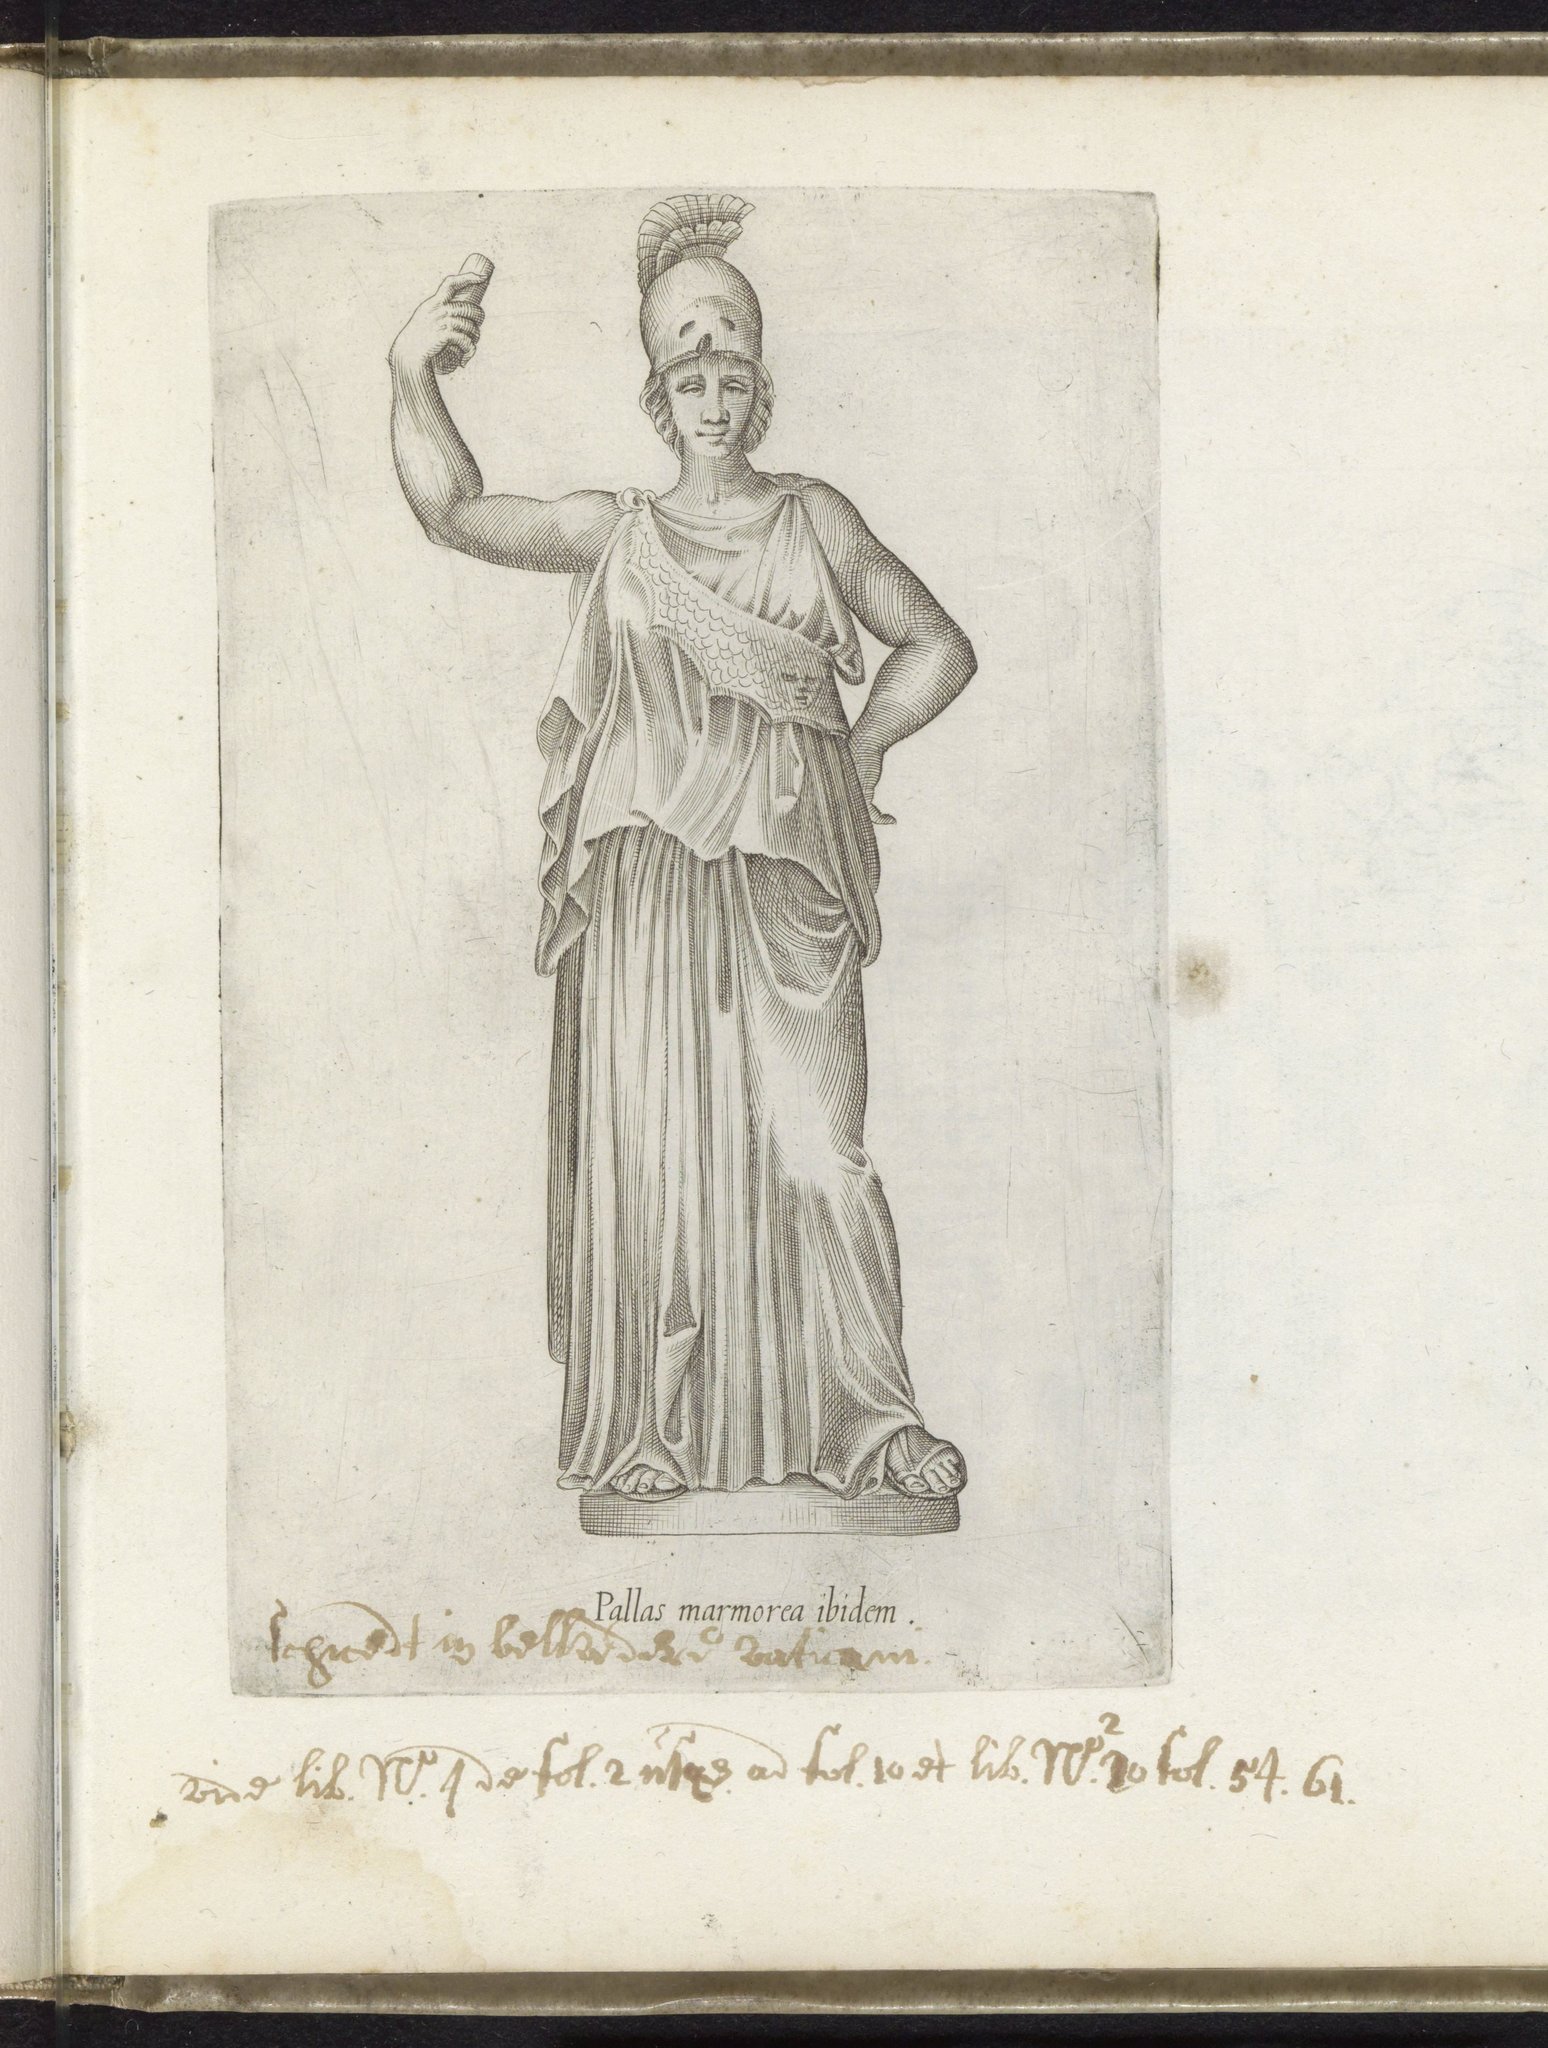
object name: print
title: Sculpturen uit de oudheid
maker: Anonymous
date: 1600-1699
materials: paper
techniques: engraving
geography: italy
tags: (story of) minerva (pallas, athena), piece of sculpture, reproduction of a piece of sculpture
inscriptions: inscription: ‘[...]/ Ende lib. No. 4 [...] fol. 2...’, number: ‘91’, inscription: ‘Ende lib. No. 4 [...] fol. 60 [...] fol. 66...’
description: Deze prent maakt deel uit van een reeks van ten minste 50 prenten van sculpturen uit de oudheid.